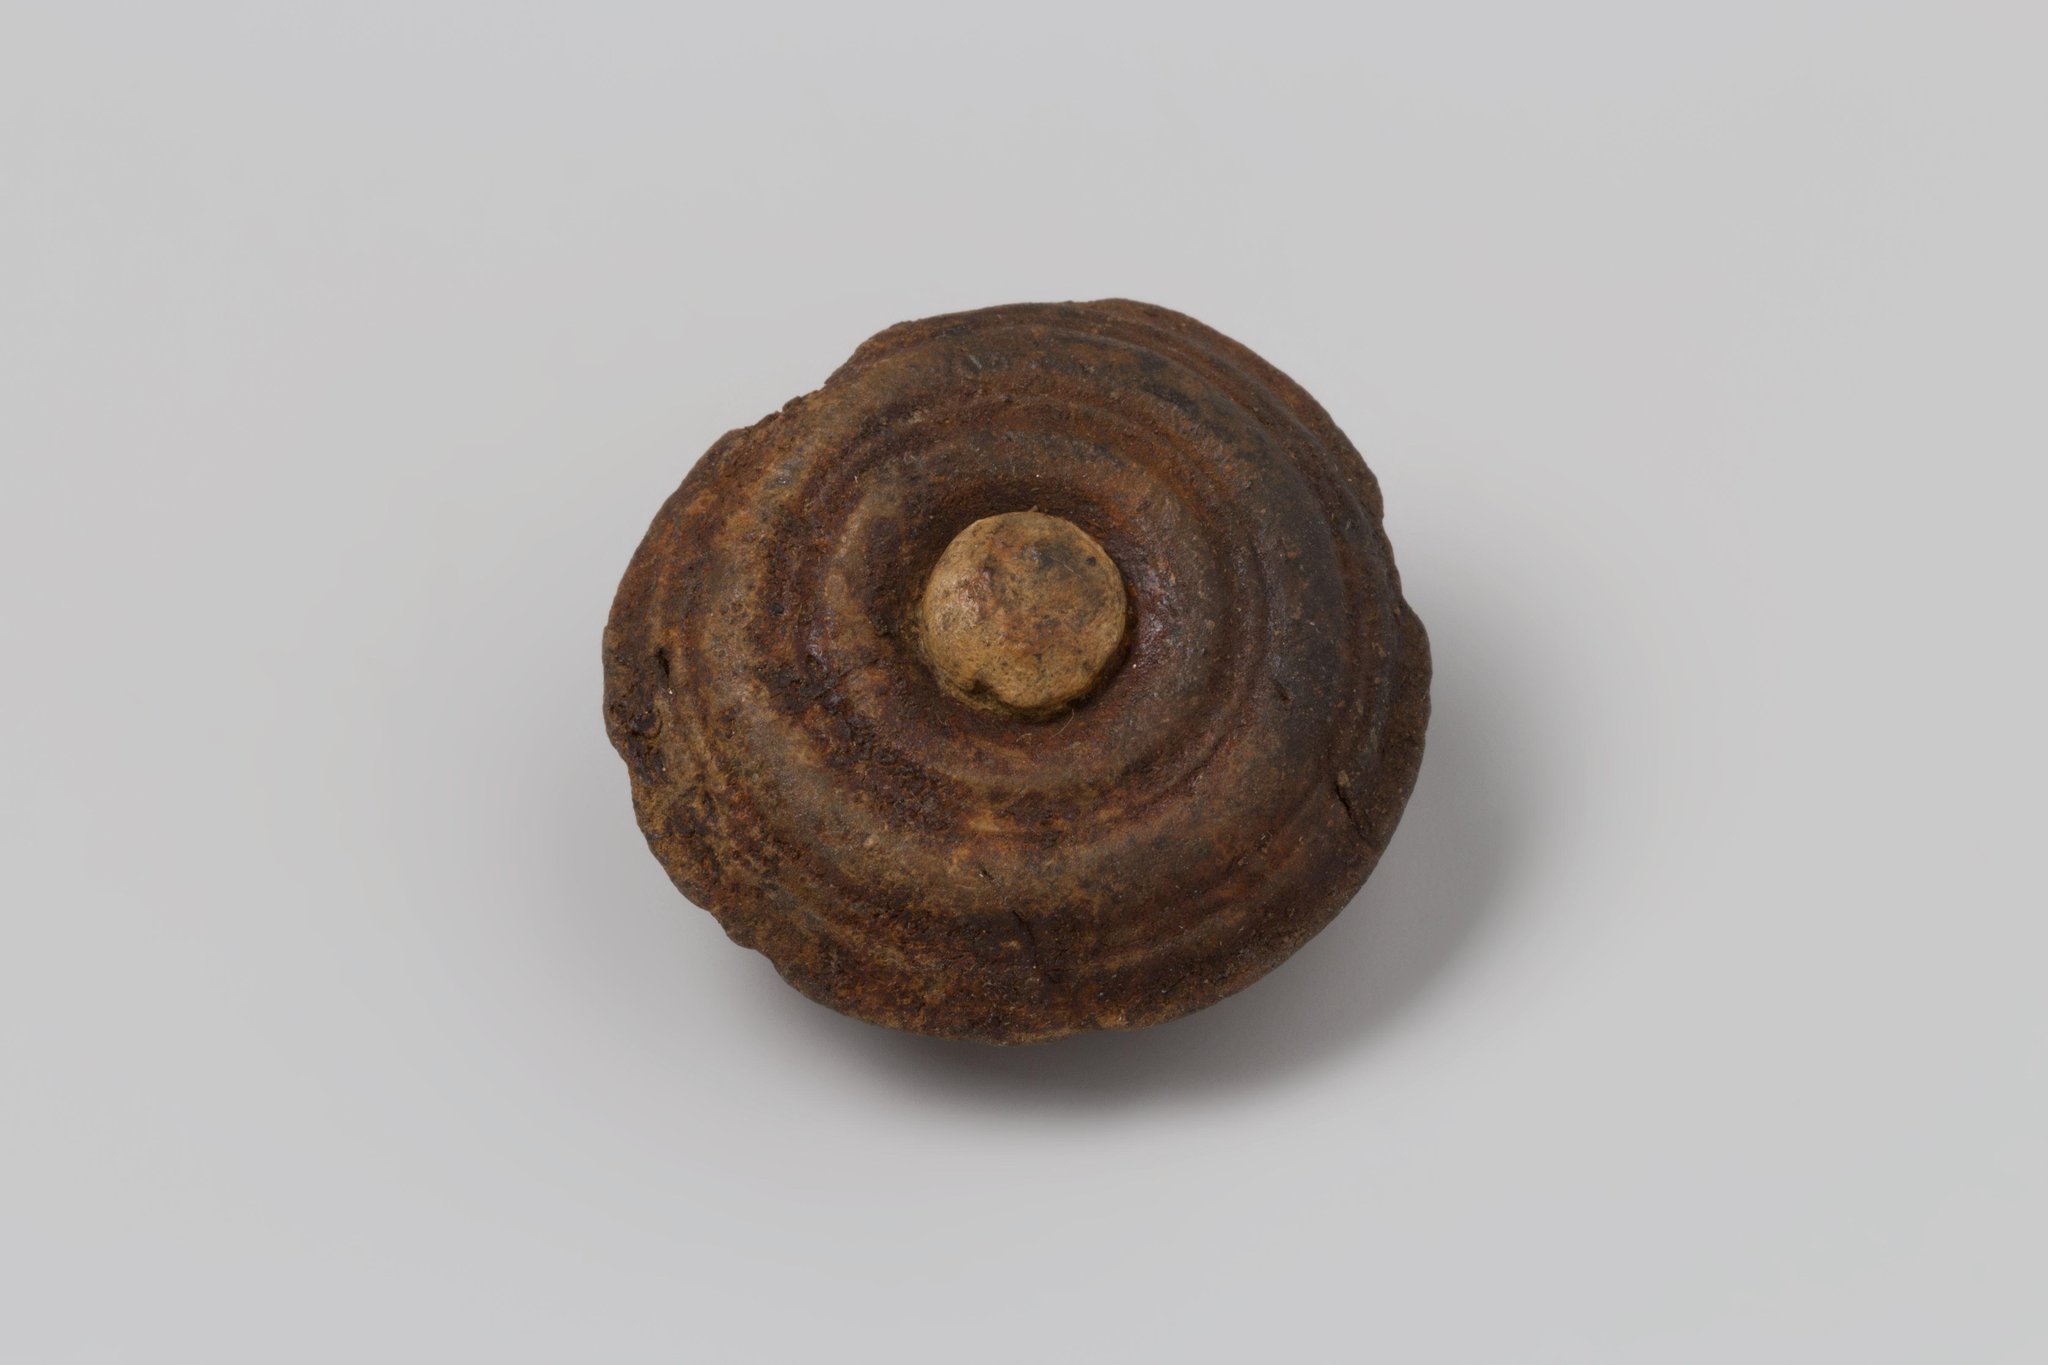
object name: lid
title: Dekselfragment uit het wrak van de Oost-Indiëvaarder Hollandia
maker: Anonymous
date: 1700-1743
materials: bone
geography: netherlands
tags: verenigde oostindische compagnie, hollandia (schip), annet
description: Parts, various, lid; circular, overhanging bevelled rim, vertical rim underneath, relieved decoration of concentric circles with circular boss in centre.